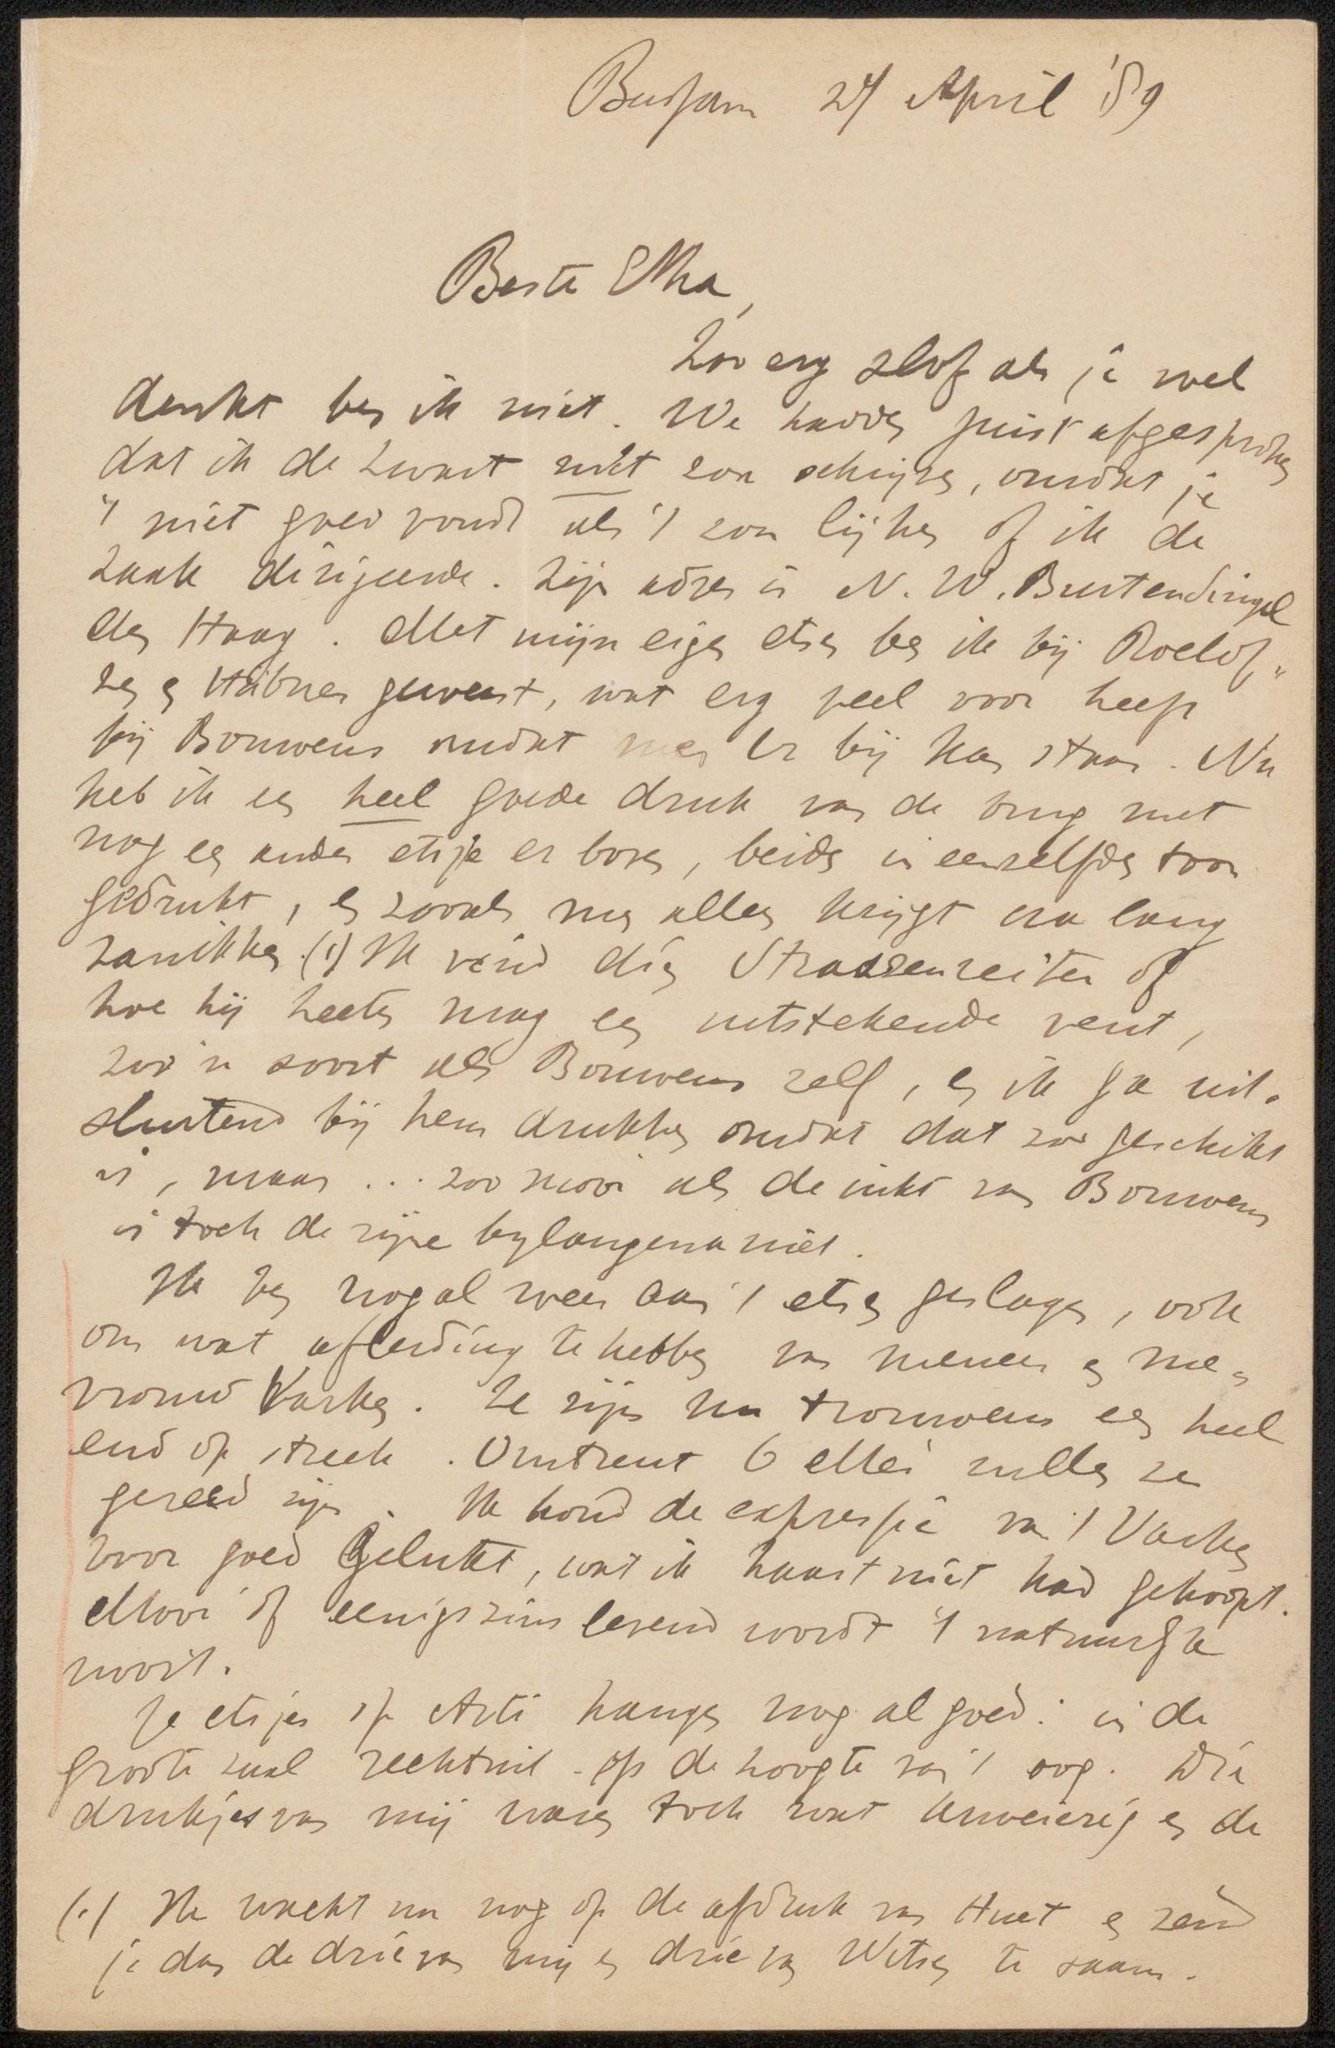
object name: letter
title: Brief aan Etha Fles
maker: jan veth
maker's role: designer, draughtsman, painter, print maker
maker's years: 1864-1925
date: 1889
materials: ink, paper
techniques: pen, writing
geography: bussum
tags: amsterdam, painter, draughtsman, willem witsen, willem de zwart, utrecht, print maker, etha fles, drawing, the graphic arts, painting (including book-illumination, miniature-painting), exhibition ~ art, historical persons (portraits and scenes from the life), the hague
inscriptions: collector's mark: ‘RPK’